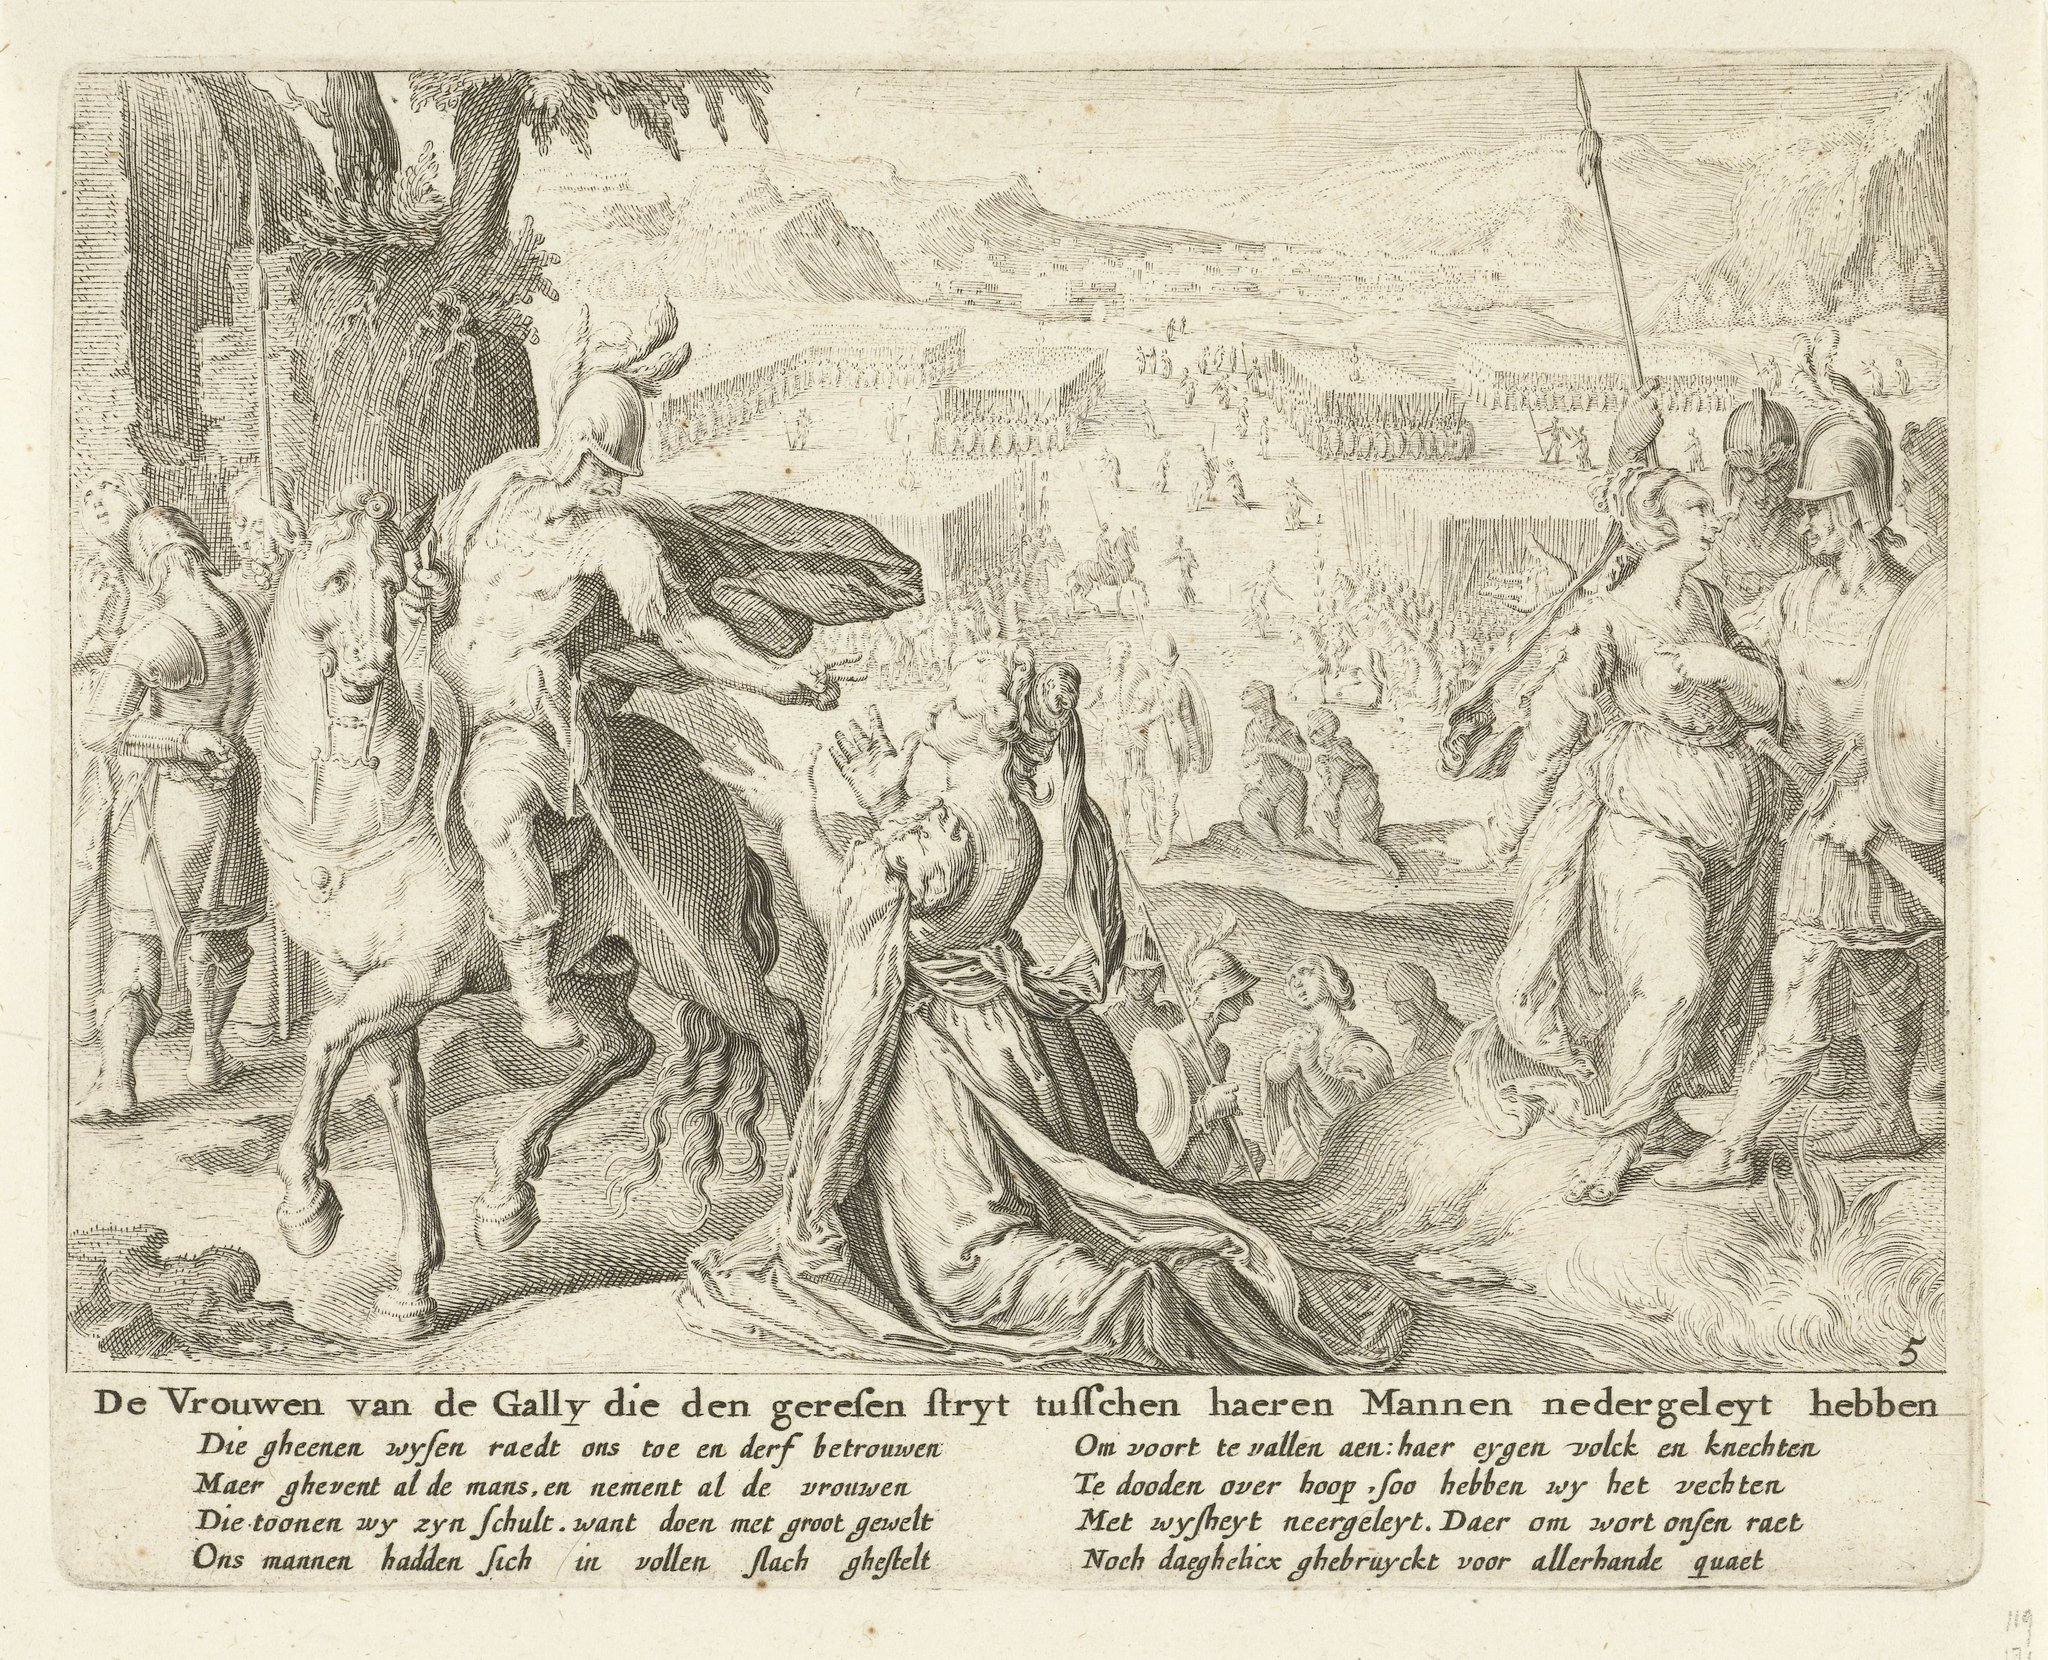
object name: print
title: De vrouwen van de Gally weerhouden hun mannen om tegen elkaar te vechten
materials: paper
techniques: engraving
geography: leiden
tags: peace negotiations, preparation for battle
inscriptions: collector's mark: Lugt 2228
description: De vrouwen van Gally weerhouden hun mannen om tegen elkaar te vechten. In groepjes van twee staan de vrouwen met hun mannen te praten. Een vrouw bidt haar man op de knieën om geen oorlog te beginnen. In het verschiet staan legers voetsoldaten klaar om ten strijde te trekken.